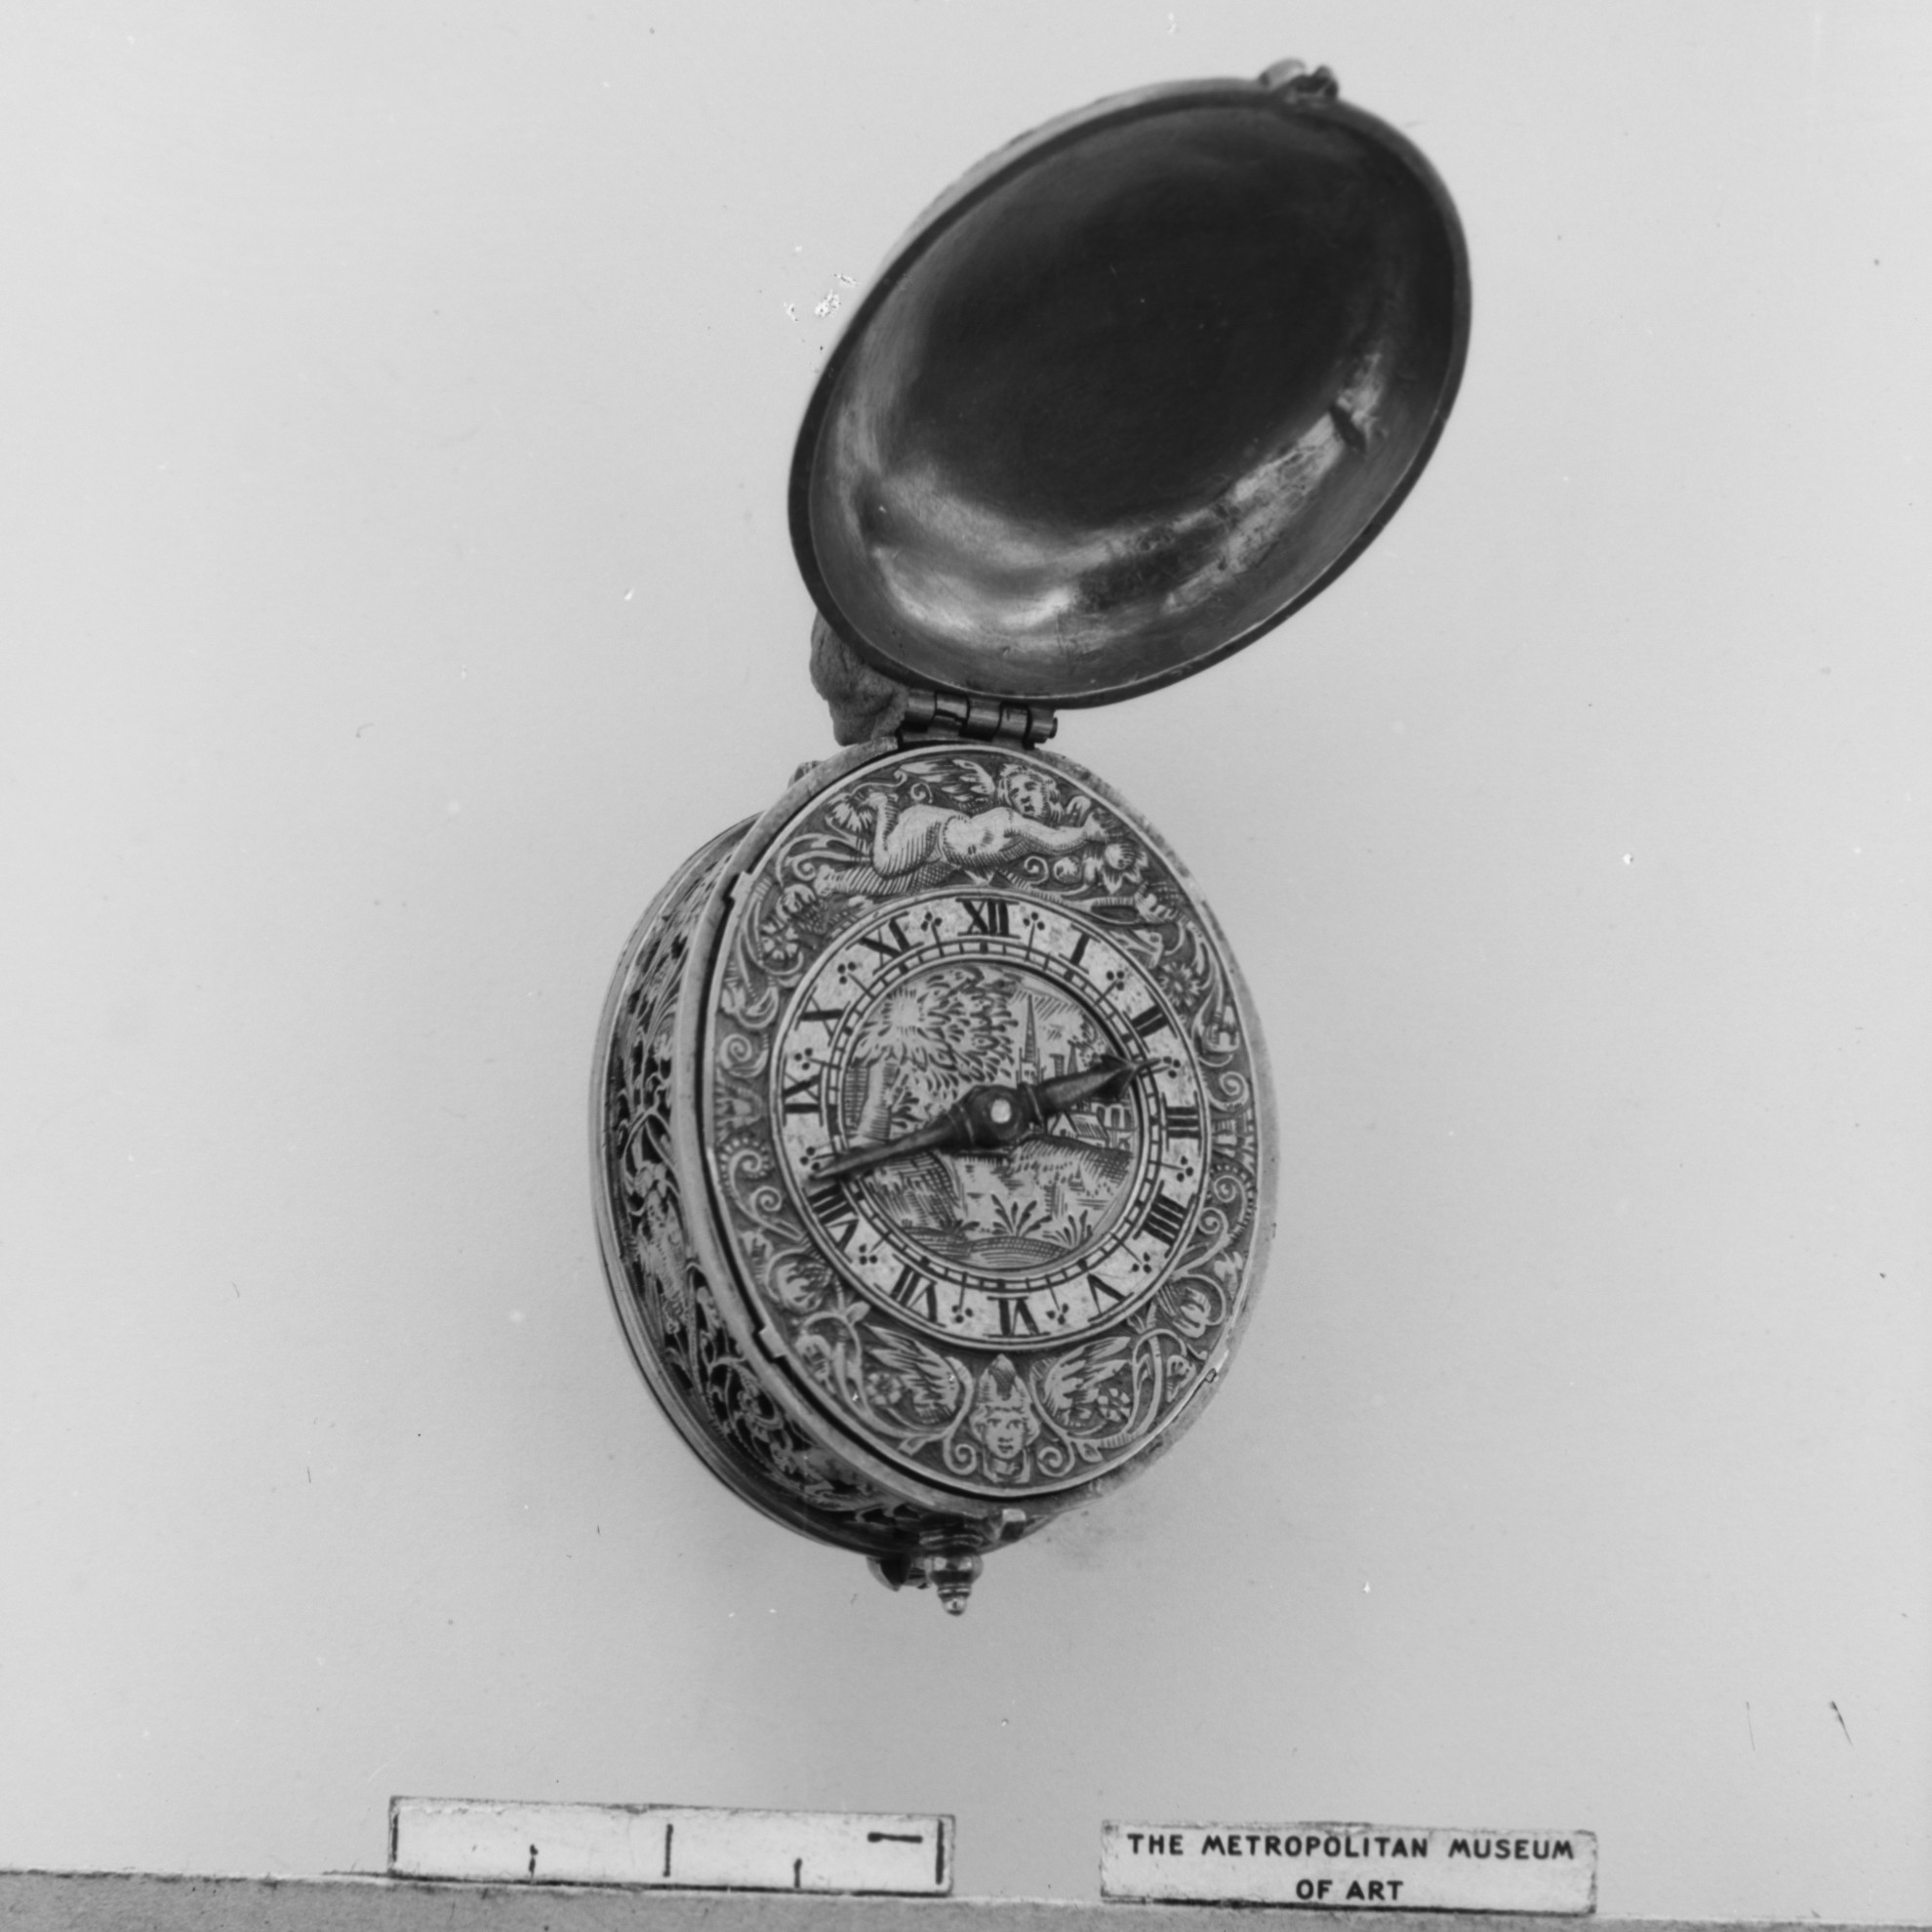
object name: watch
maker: nicolas forfaict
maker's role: maker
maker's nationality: french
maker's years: 1580-1615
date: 1605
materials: gilt, metal, silver